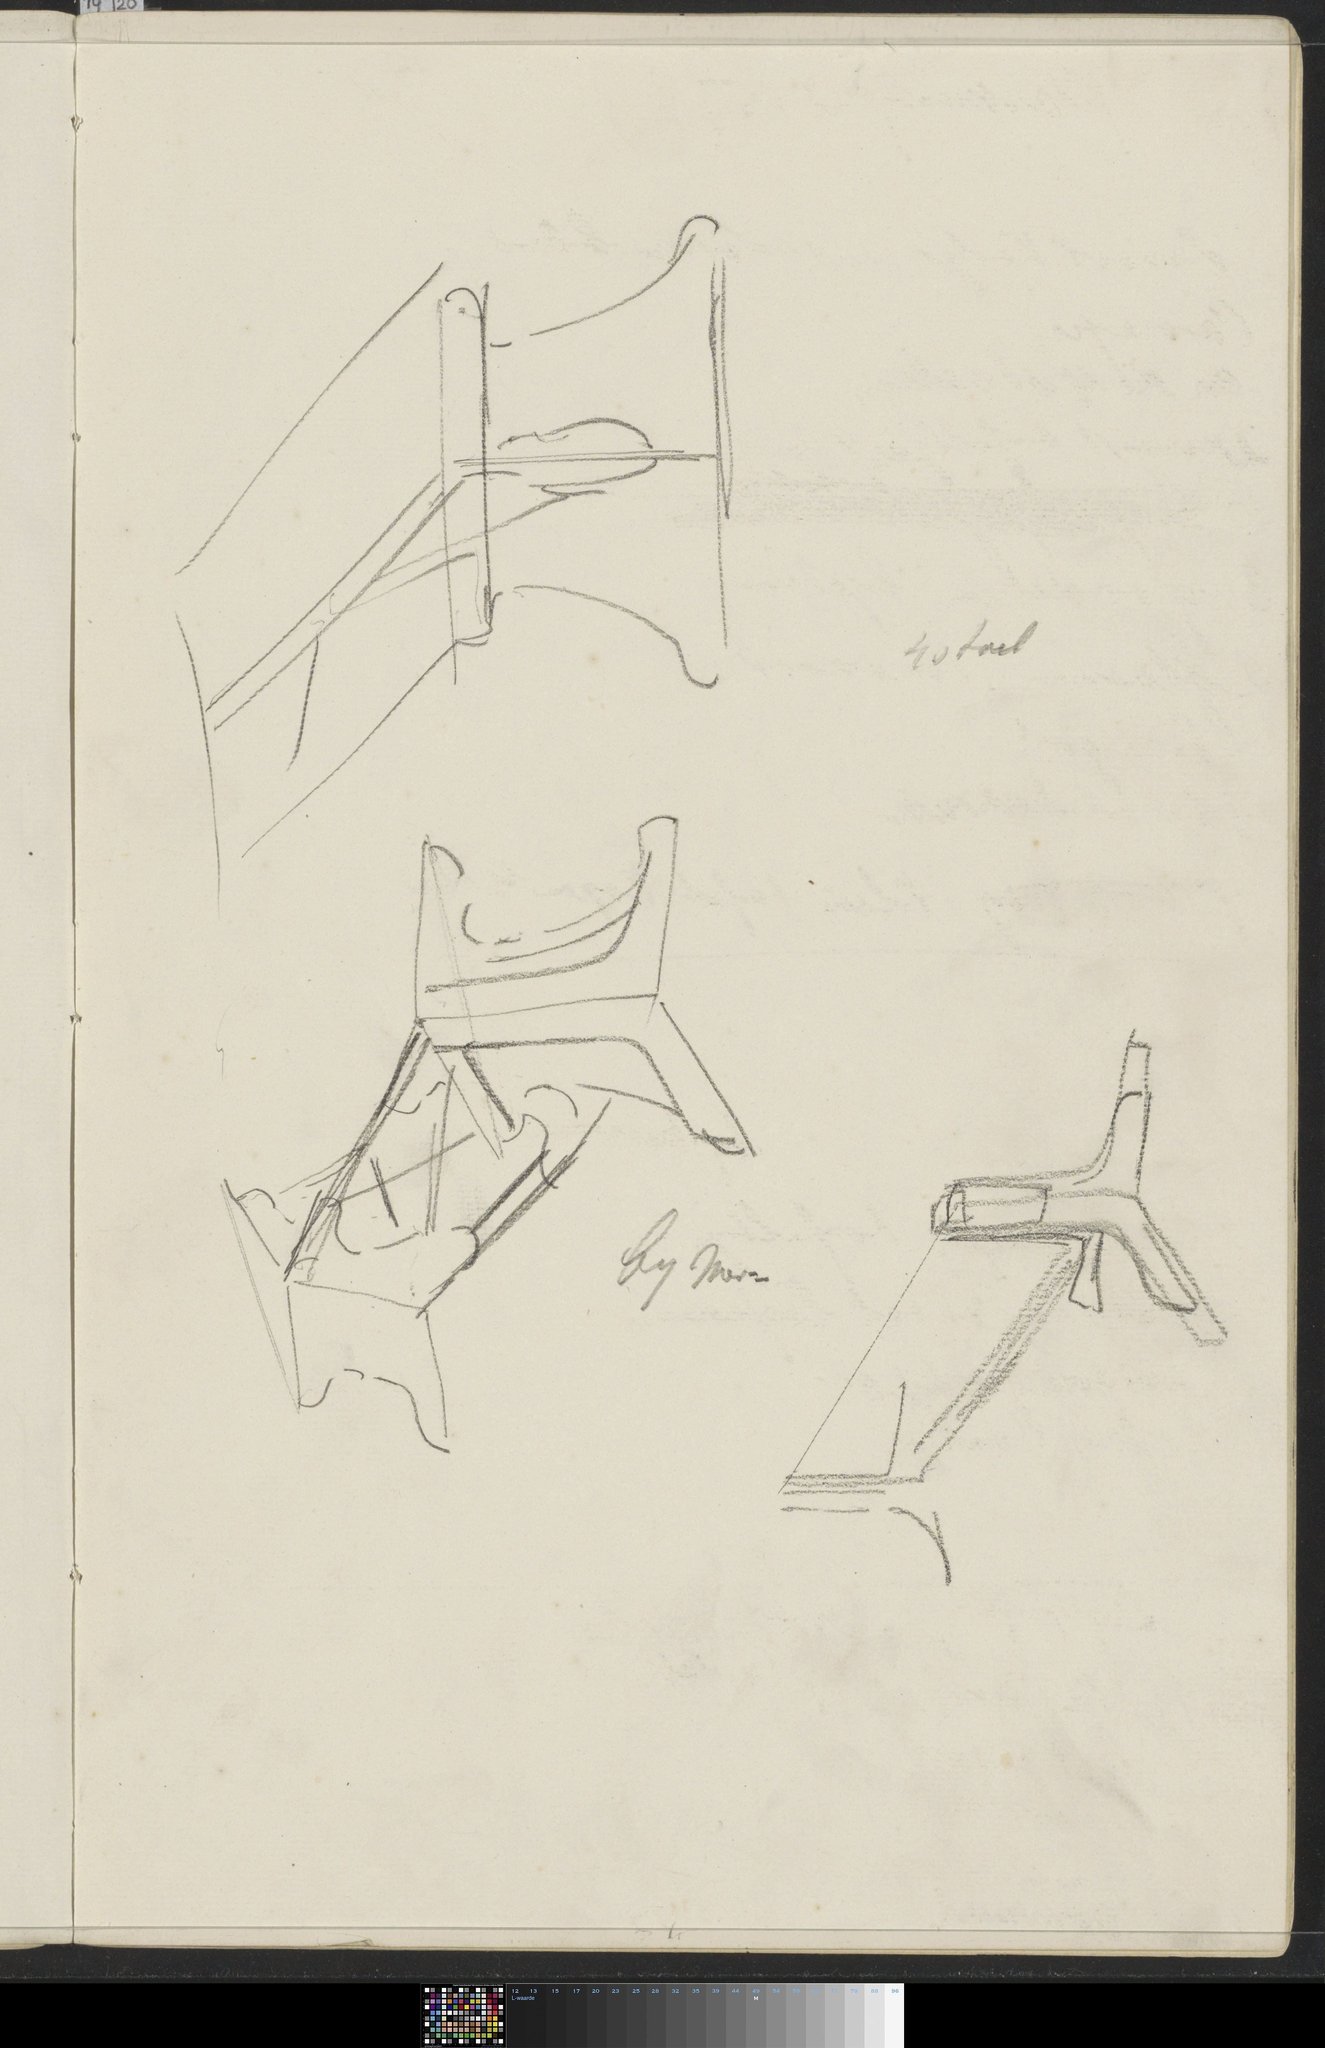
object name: sketchbook leaf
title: Stoelen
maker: carel adolph lion cachet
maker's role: draughtsman, print maker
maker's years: 1864-1945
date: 1897-1898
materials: chalk, paper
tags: chair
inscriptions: annotation: ‘4 staal/ bij [...]’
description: Blad 19 recto uit een schetsboek met 29 bladen.